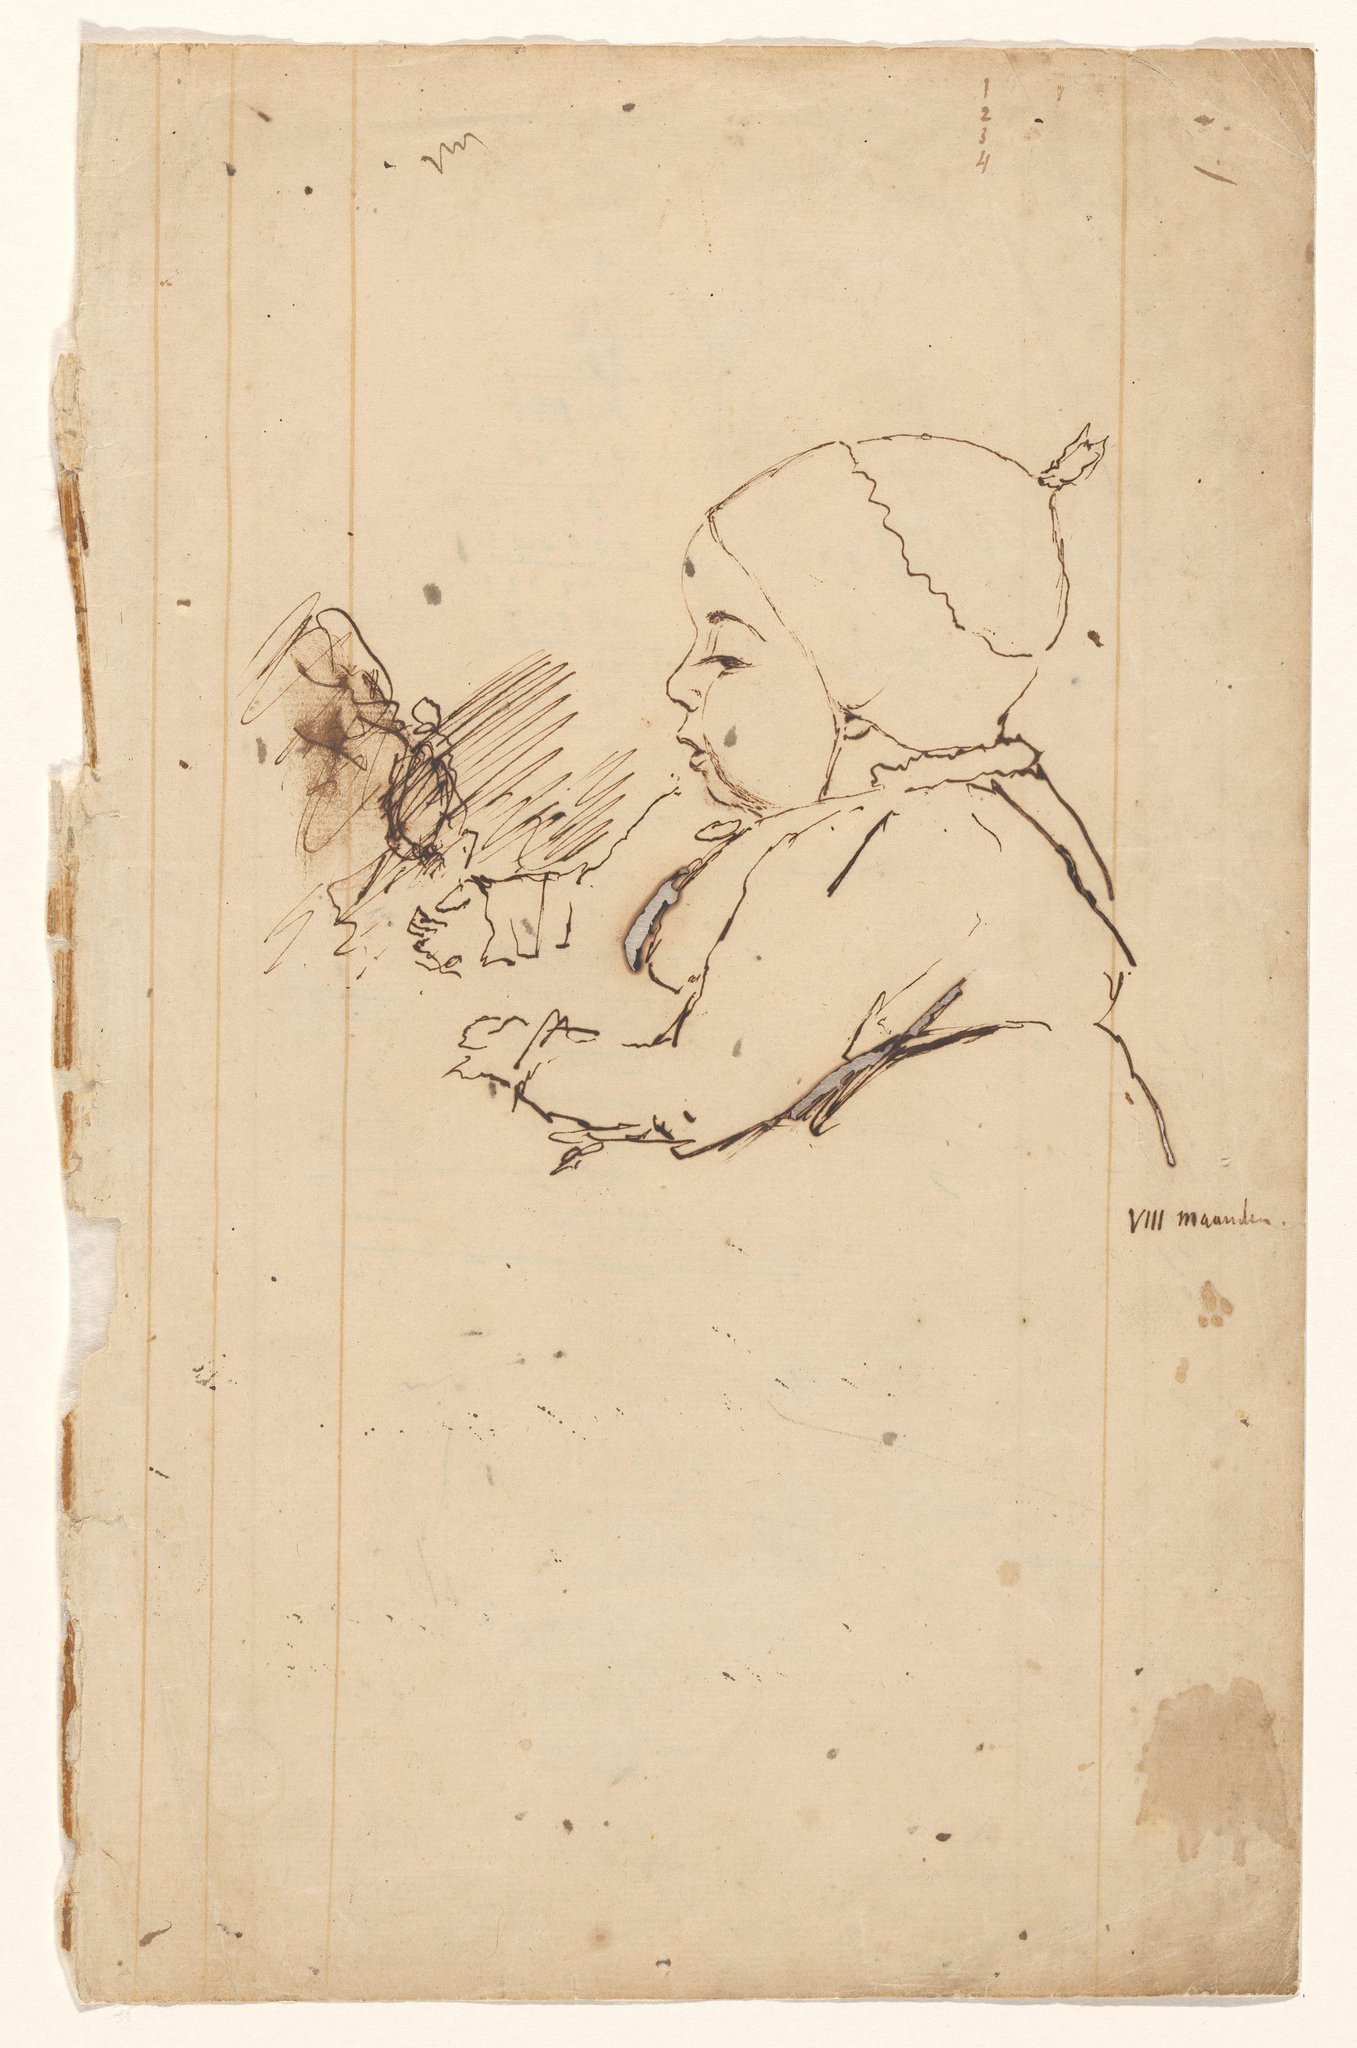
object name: drawing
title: Portret van een kind van acht maanden.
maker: jan willem van borselen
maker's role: draughtsman, print maker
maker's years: 1825-1892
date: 1835-1892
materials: ink, paper, pencil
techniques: pen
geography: the hague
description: Portret van een kind van acht maanden, op de achterkant wiskundige aantekeningen.